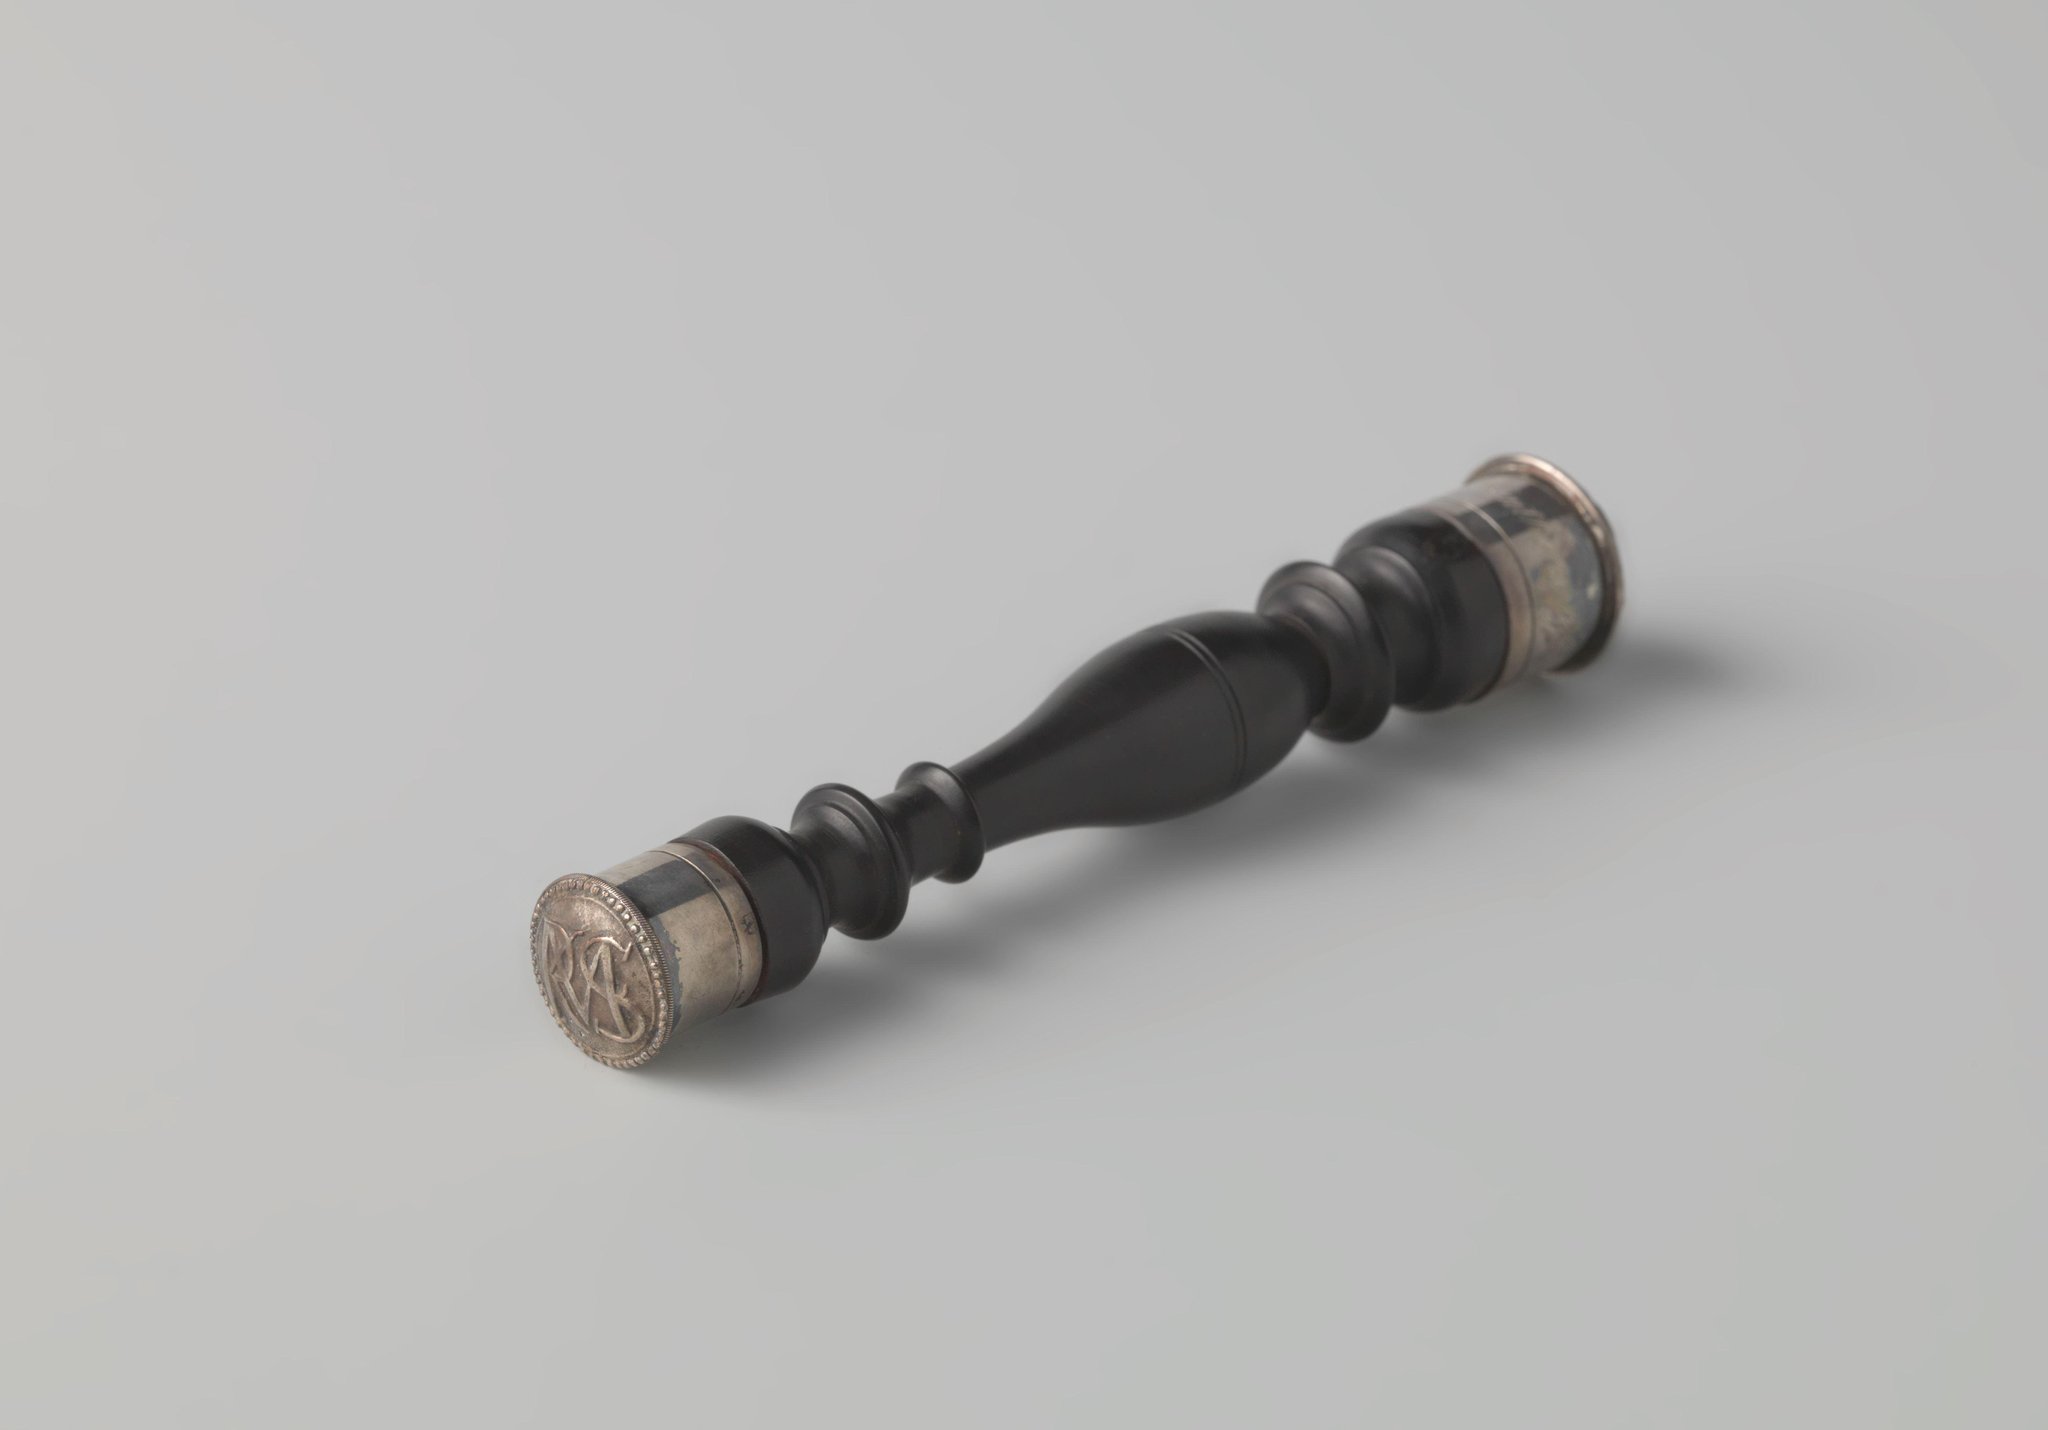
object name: makelaarsstok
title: Makelaarsstokje van F.A. Gluysteen, makelaar te Amsterdam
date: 1837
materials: wood, silver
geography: amsterdam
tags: amsterdam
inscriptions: hallmark, maker's mark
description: Het balustervormige, meervoudig geprofileerde ebbenhouten stokje heeft een breed en een smal uiteinde, beide gevat in een gegoten zilveren dop. De doppen hebben een rechte, gladde wand en een licht gebold, iets uitstekende bovenzijde, waarvan de rand is gemarkeerd met een fijne kabel. De grote dop is in reliëf versierd met het gekroonde, door leeuwen gehouden stadswapen van Amsterdam, de kleine met de letters MKLRSG in monogram binnen een parelrand voor het Amsterdamse Makelaarsgilde. Op de wand van de kleine dop is het jaartal 1837 gegraveerd, boven een rondlopende filetrand; op de wand van de grote dop de naam Frederik Anthony Gluysteen, boven een rondlopende filetrand.